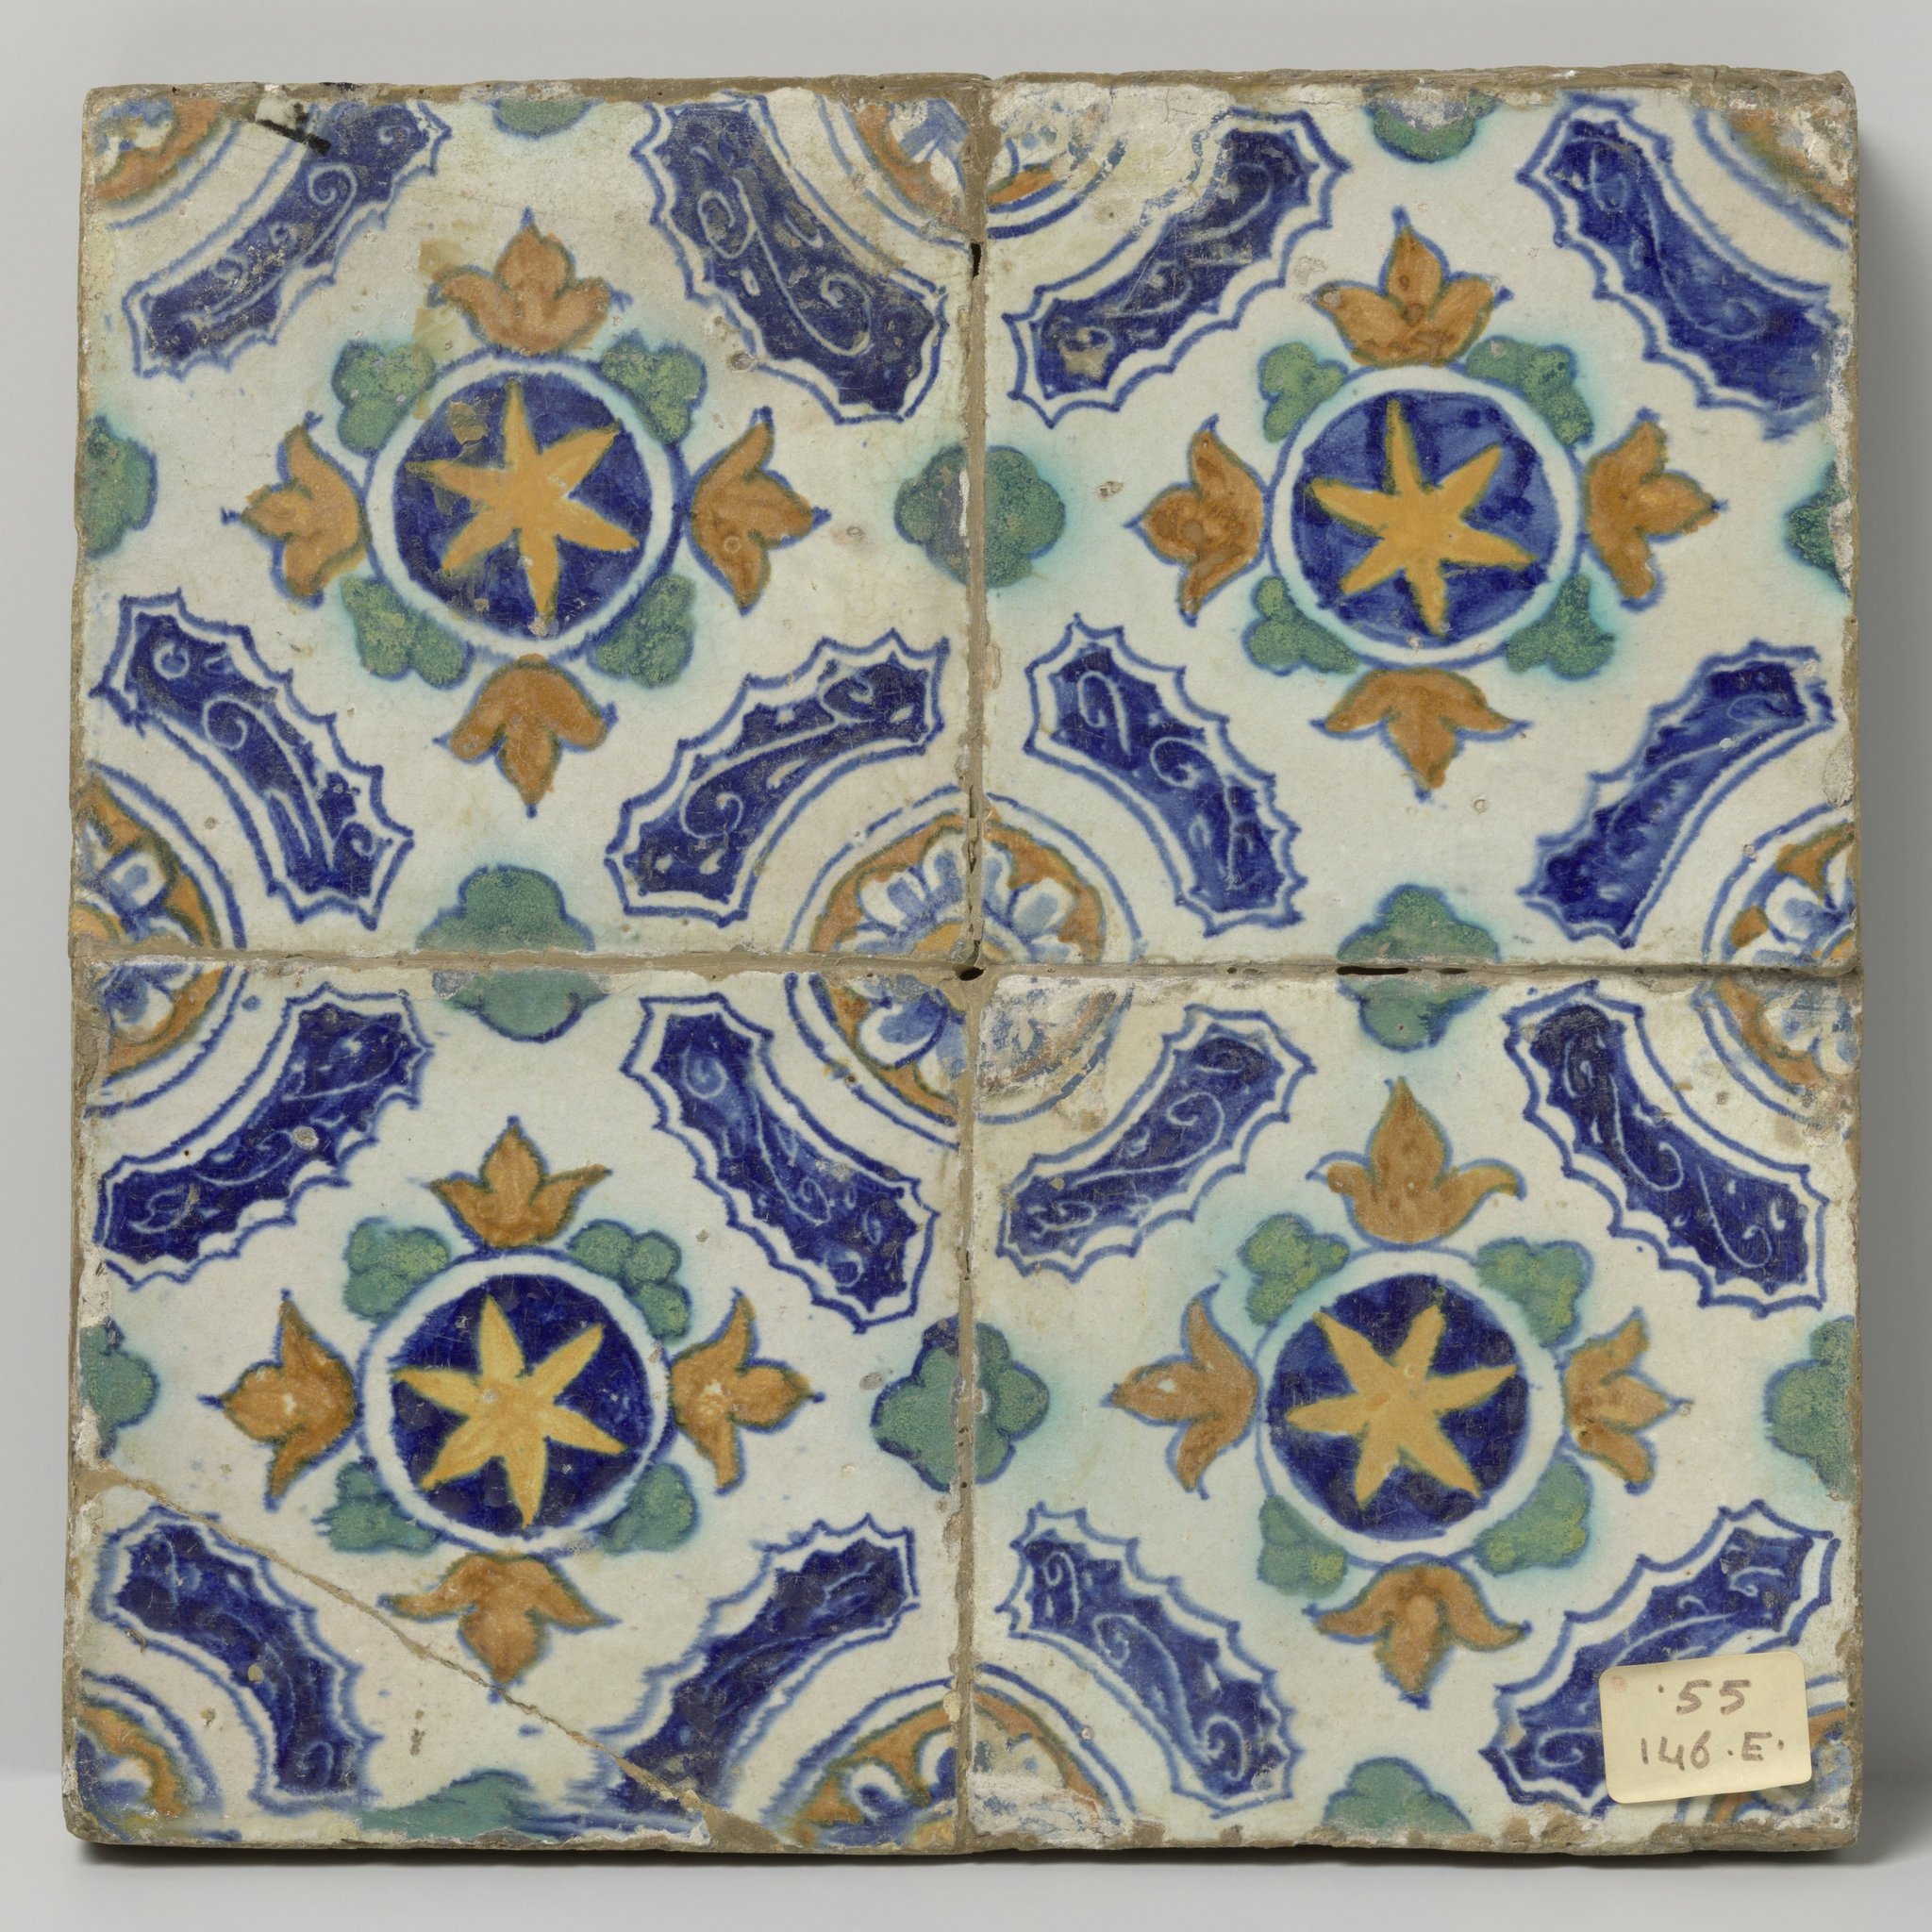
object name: tegelveld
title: Veld van vier tegels met sterren en bladeren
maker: Anonymous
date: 1600-1625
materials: earthenware, glaze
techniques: maiolica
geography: netherlands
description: Veld van vier tegels (2 x 2) elk met een veelkleurig (blauw, geel, groen en oranje) geschilderde ster in een cirkel versierd met bladeren, omgeven door langwerpige vakken met ranken. In de hoeken, een kwart rozet.